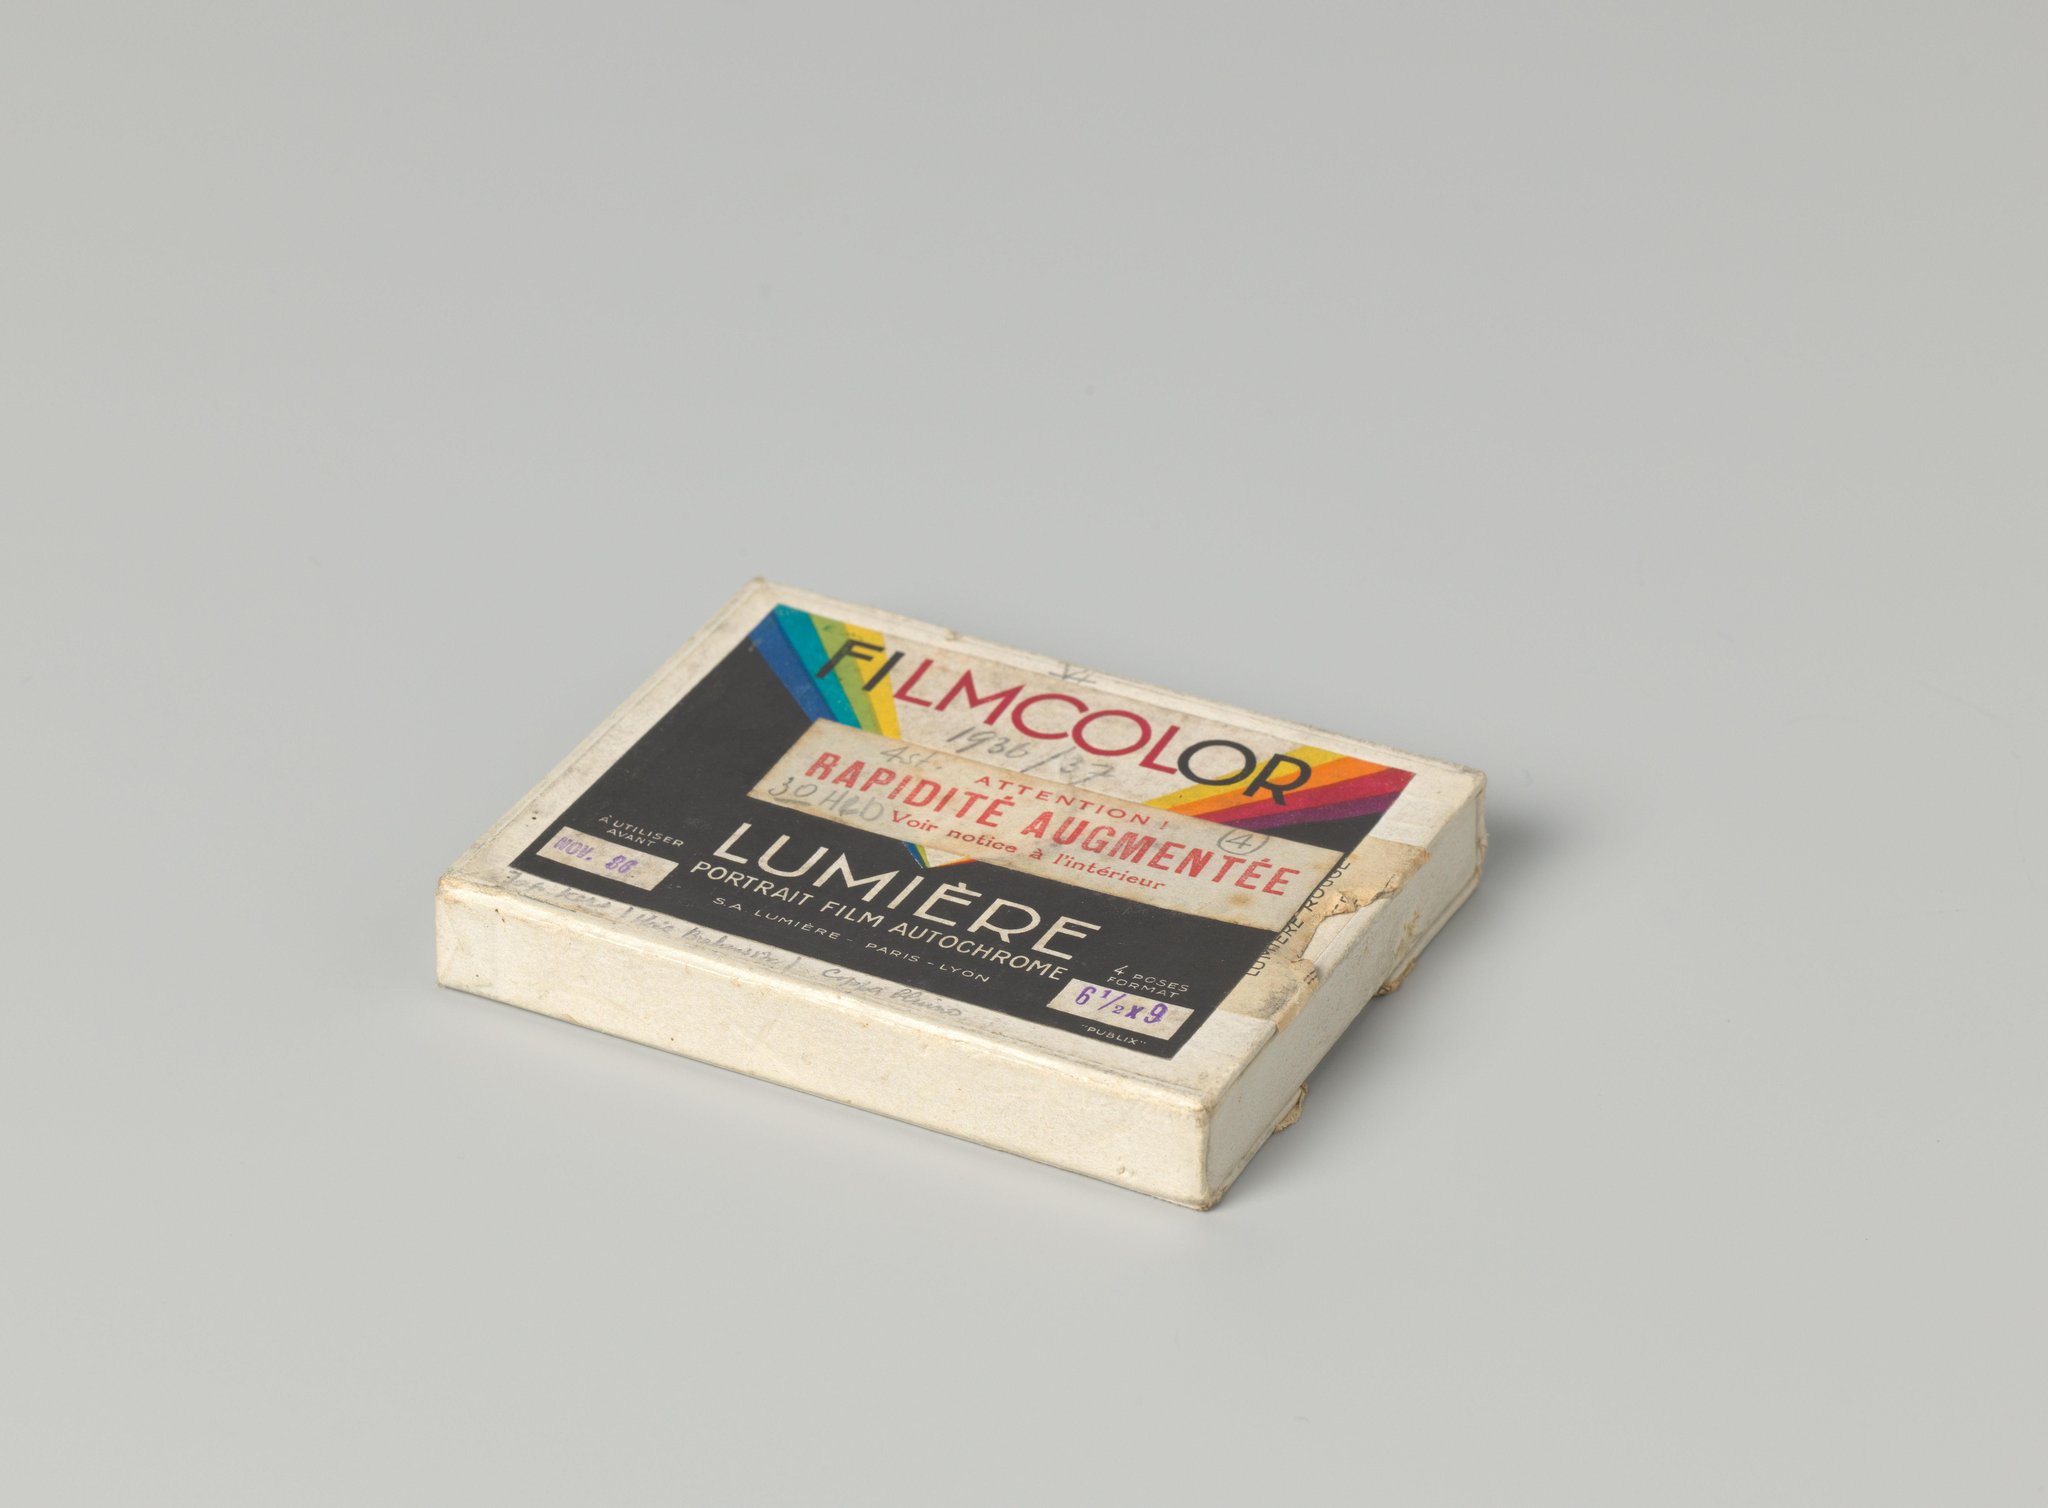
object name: box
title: Doos voor autochromes van Lumière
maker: lumière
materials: cardboard, paper, tape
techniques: printing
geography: france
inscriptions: inscription: ‘VI/ 1936/37’, date: ‘À UTILISER/ AVANT/ NOV. 36’